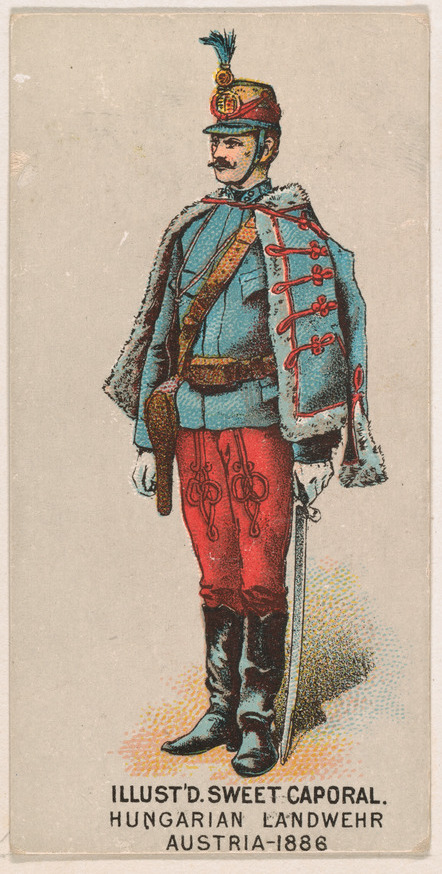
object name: print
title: Hungarian Landwehr, Austria, 1886, from the Military Series (N224) issued by Kinney Tobacco Company to promote Sweet Caporal Cigarettes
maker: kinney brothers tobacco company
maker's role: publisher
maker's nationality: american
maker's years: 1869-2011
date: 1888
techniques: color lithograph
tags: soldiers,men